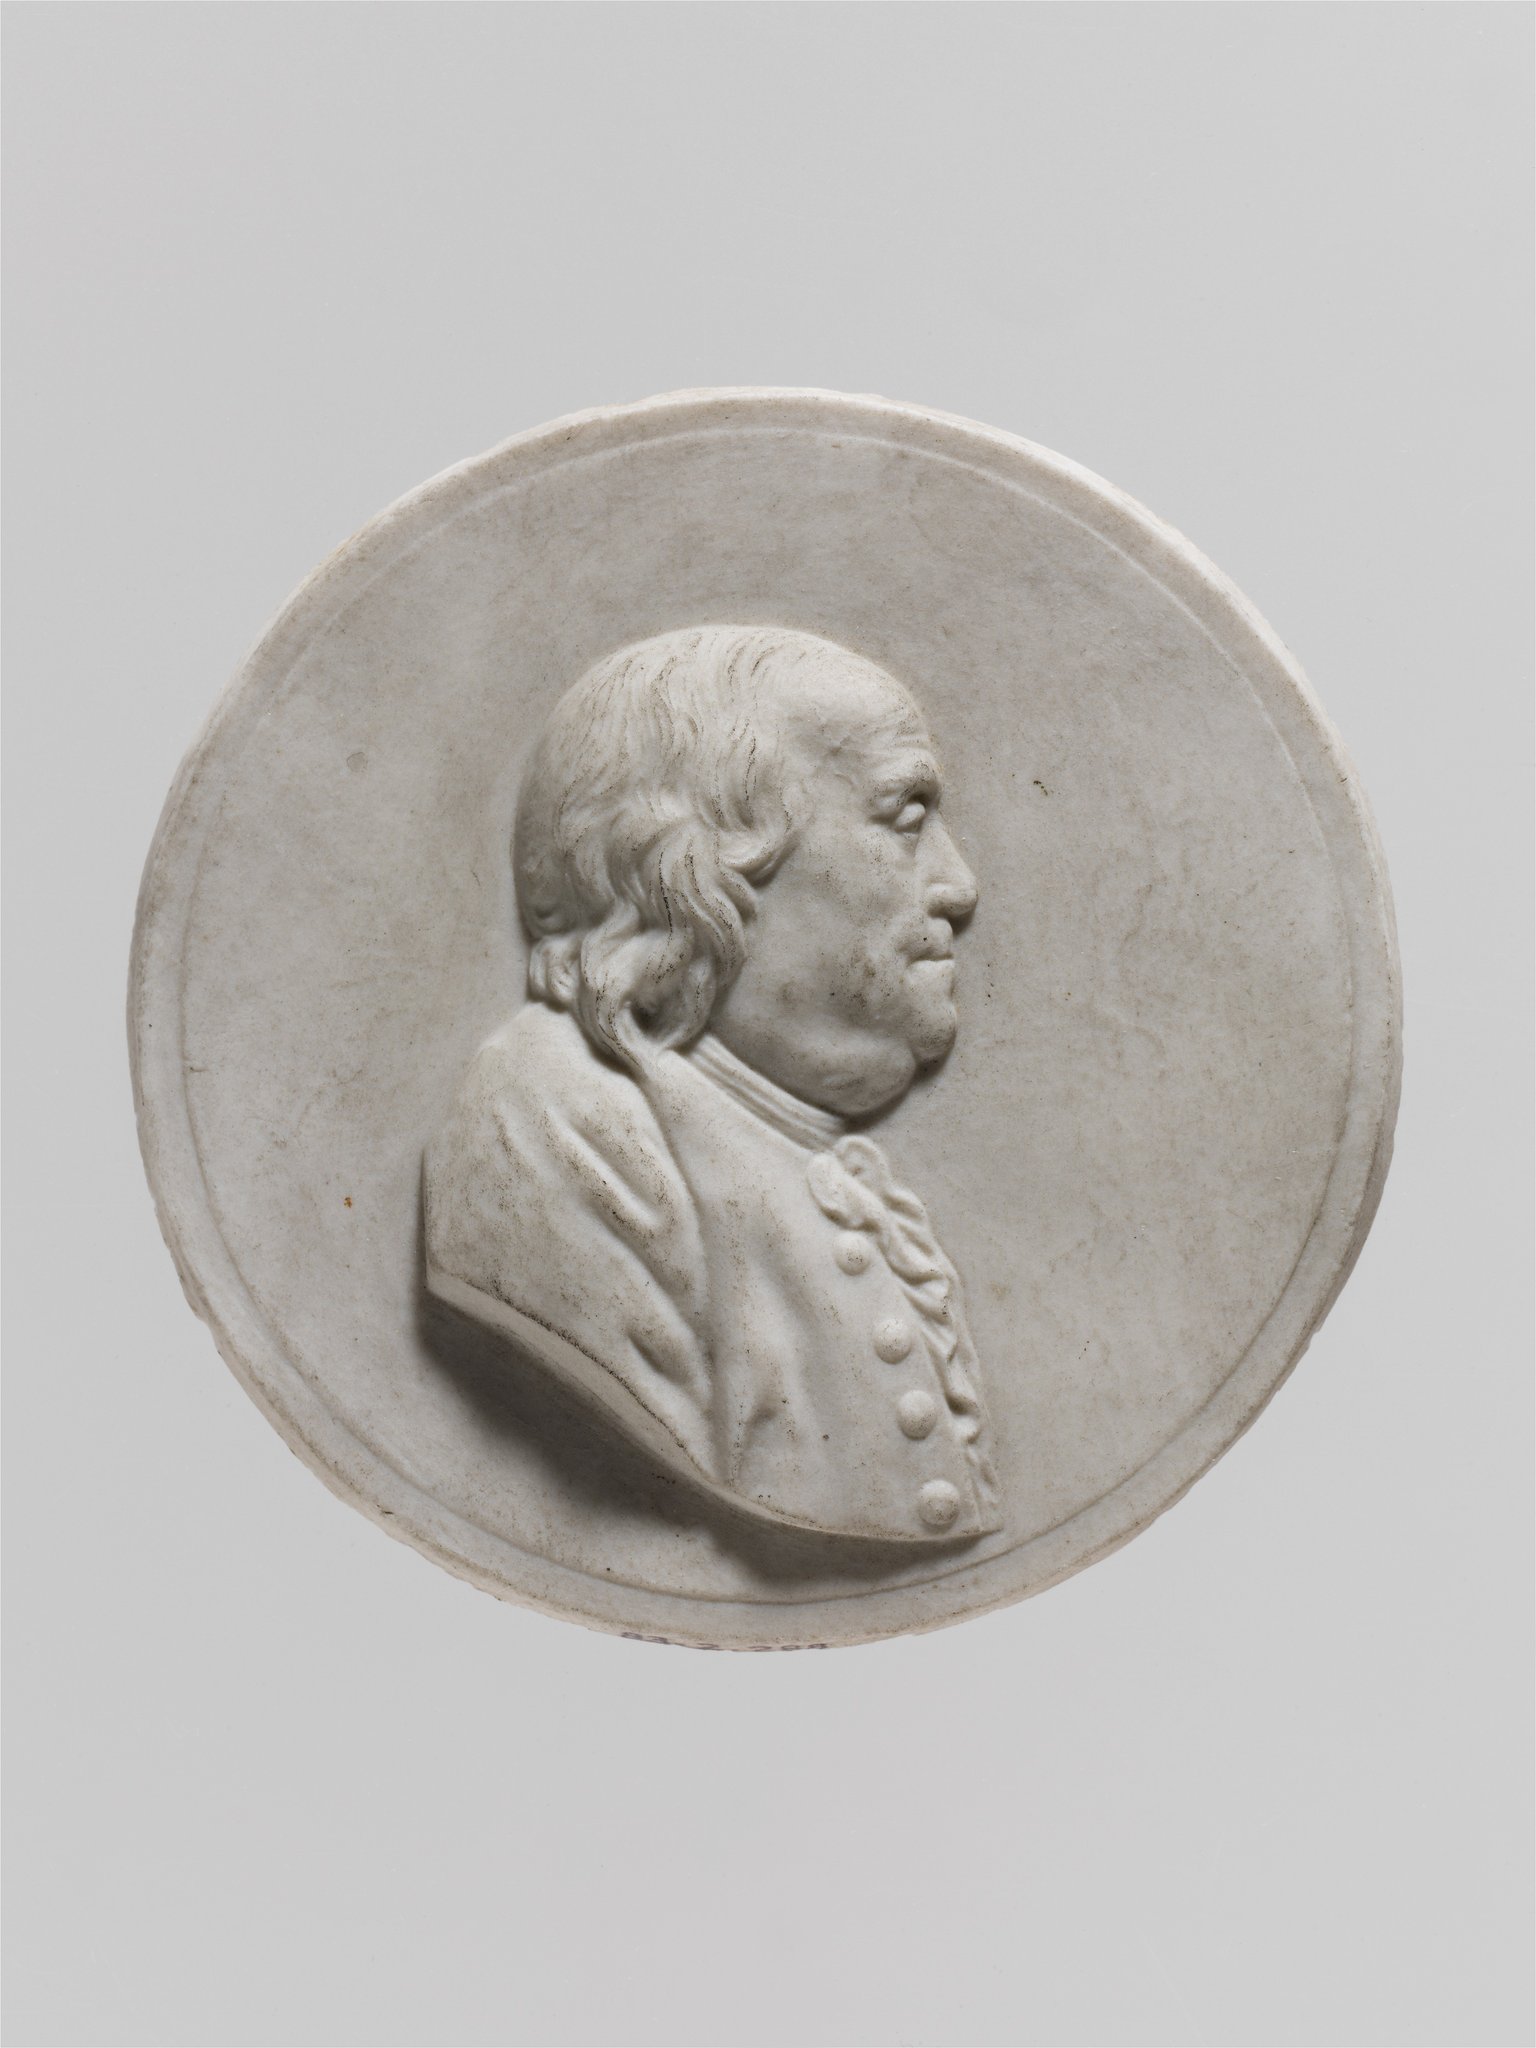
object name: plaque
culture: french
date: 1776-1883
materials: porcelain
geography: france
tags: men,profiles